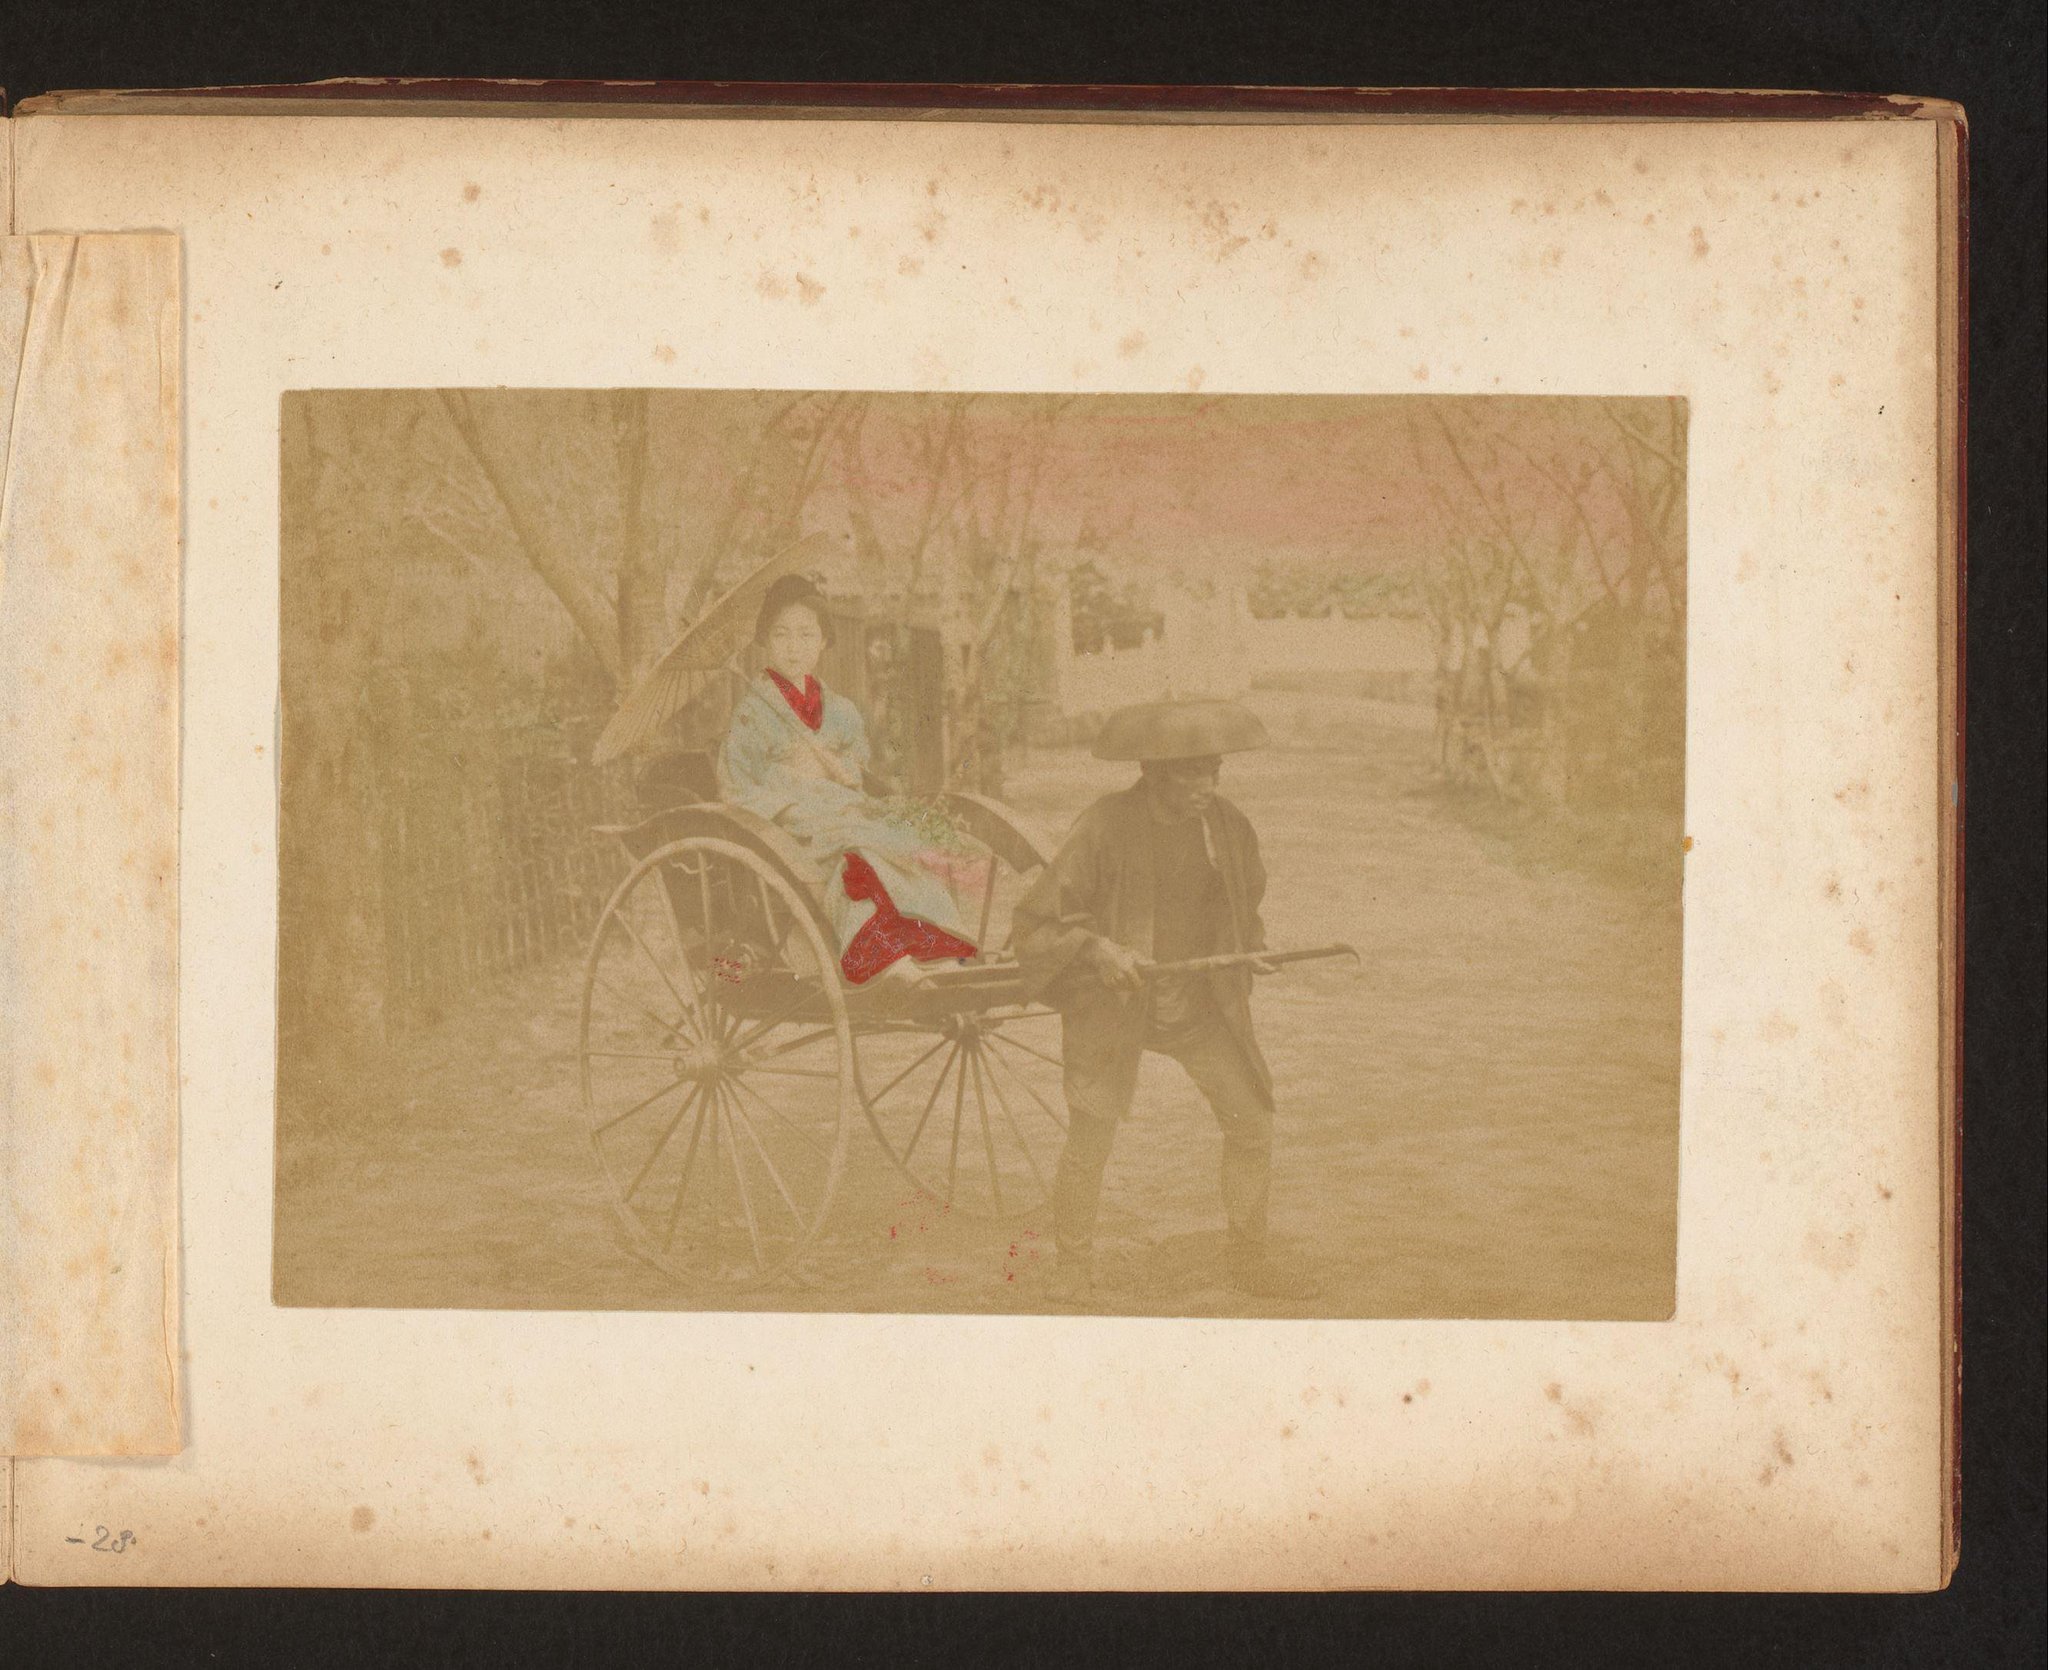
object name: photograph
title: Japanse vrouw in een riksja, getrokken door een man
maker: Anonymous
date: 1851-1900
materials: paper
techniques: albumen print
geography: japan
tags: rickshaw, adult woman, adult man, japan